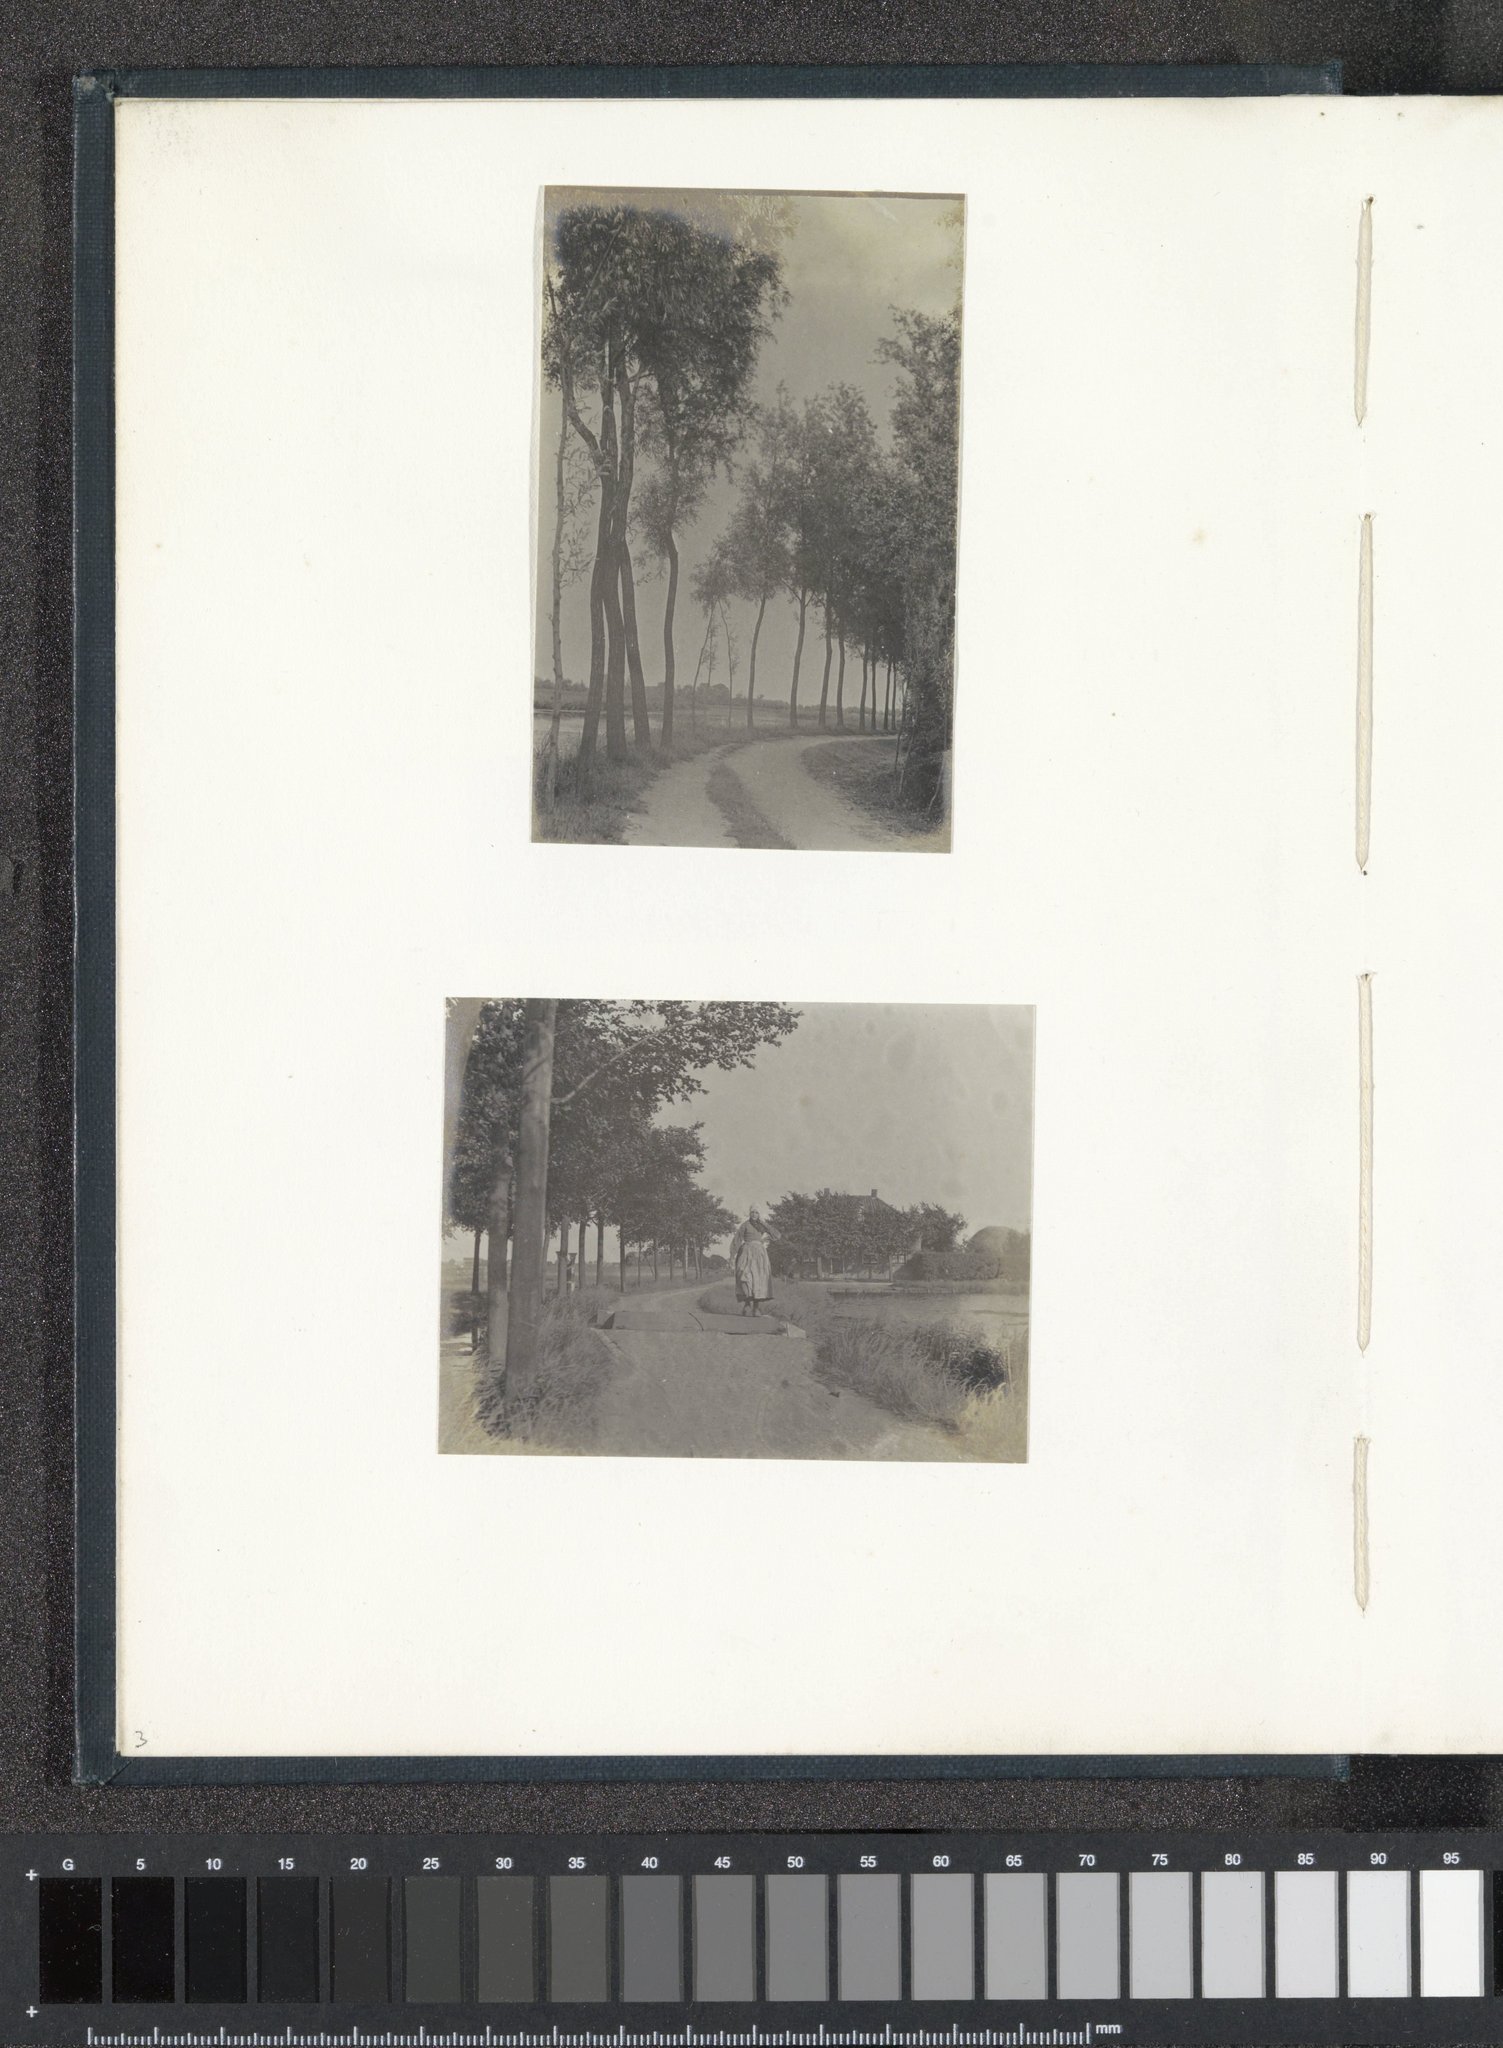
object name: photograph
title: Laan met bocht, vermoedelijk in de buurt van Volendam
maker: george hidderley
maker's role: fotograaf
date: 1900-1910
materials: paper, photographic support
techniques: gelatin silver print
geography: volendam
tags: forest path or lane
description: Onderdeel van fotoalbum met opnames van Volendam, Dordrecht, Gorinchem en Woudrichem.